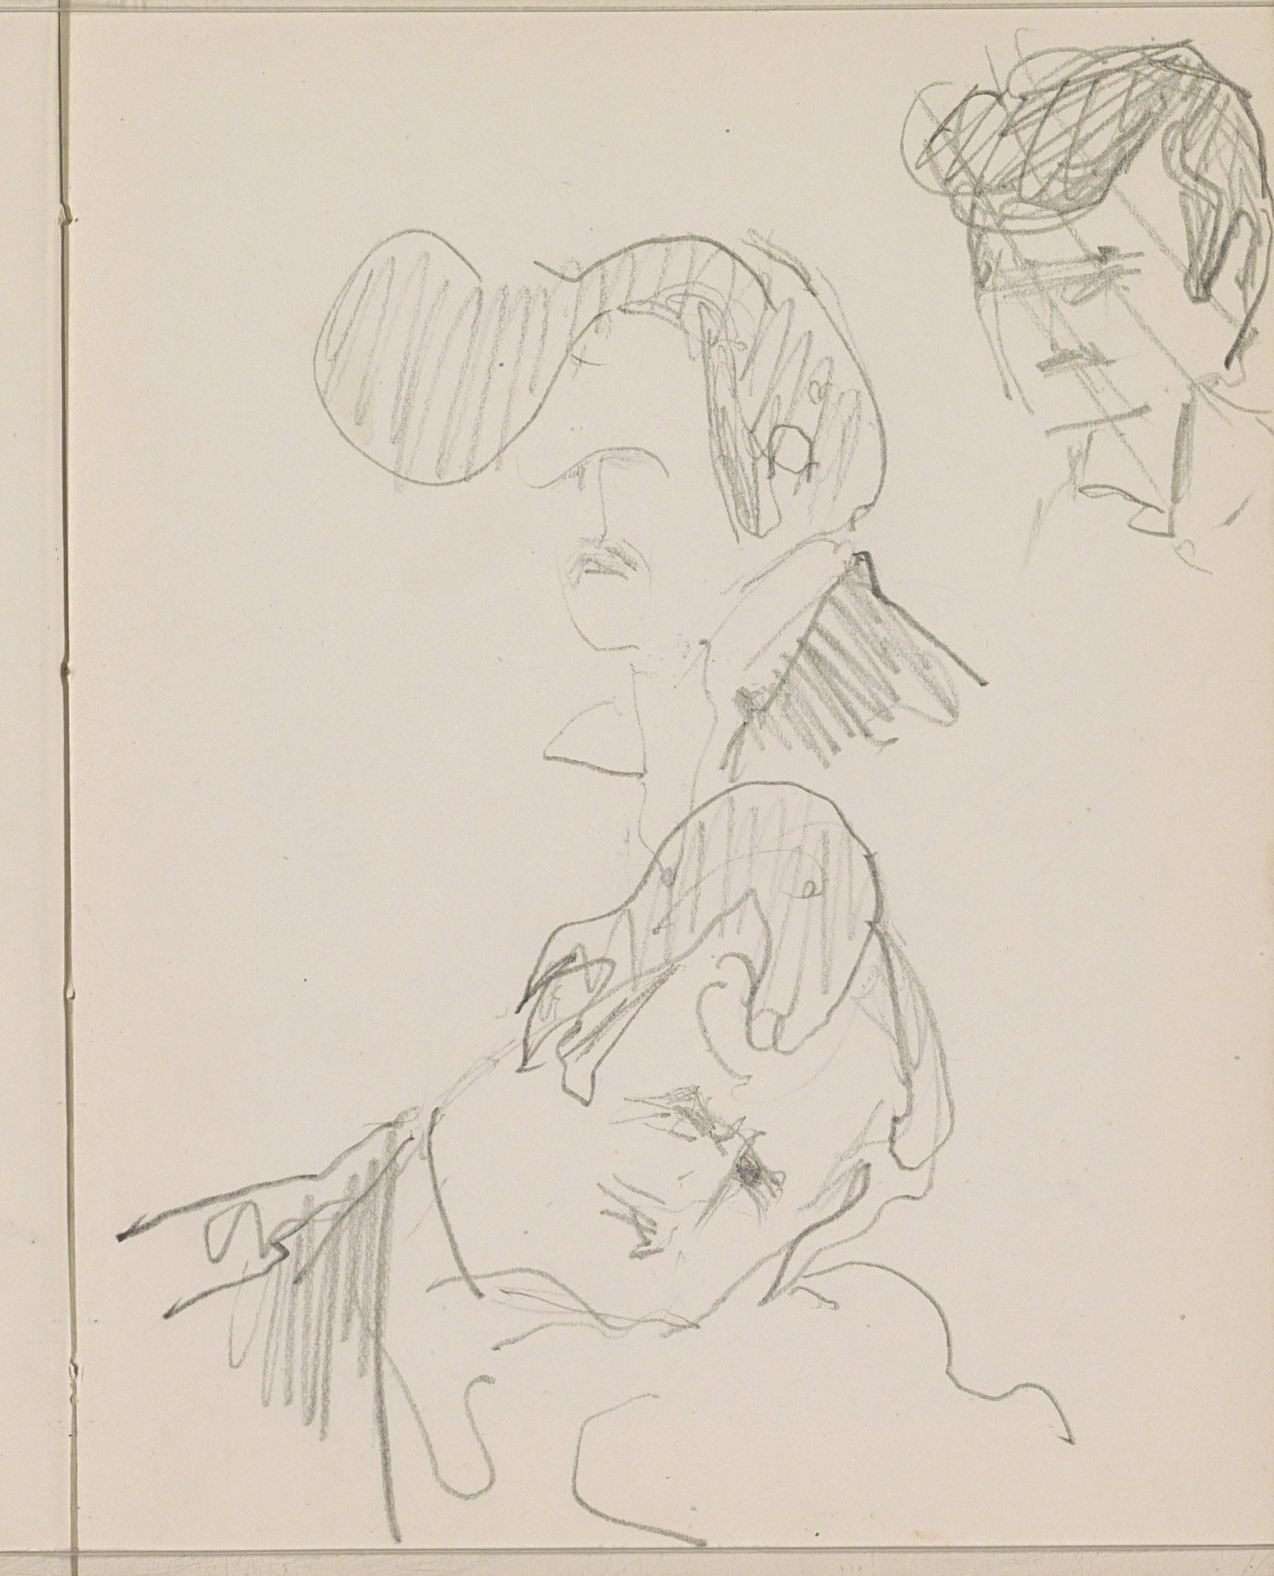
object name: sketchbook leaf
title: Hoofd van een man met een kuif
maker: reijer stolk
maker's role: draughtsman, print maker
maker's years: 1896-1945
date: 1916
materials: paper, pencil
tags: head (human), lock of hair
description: Tevens studies van de hoofden van een man en jongen. Blad 37 recto uit een schetsboek met 72 bladen.